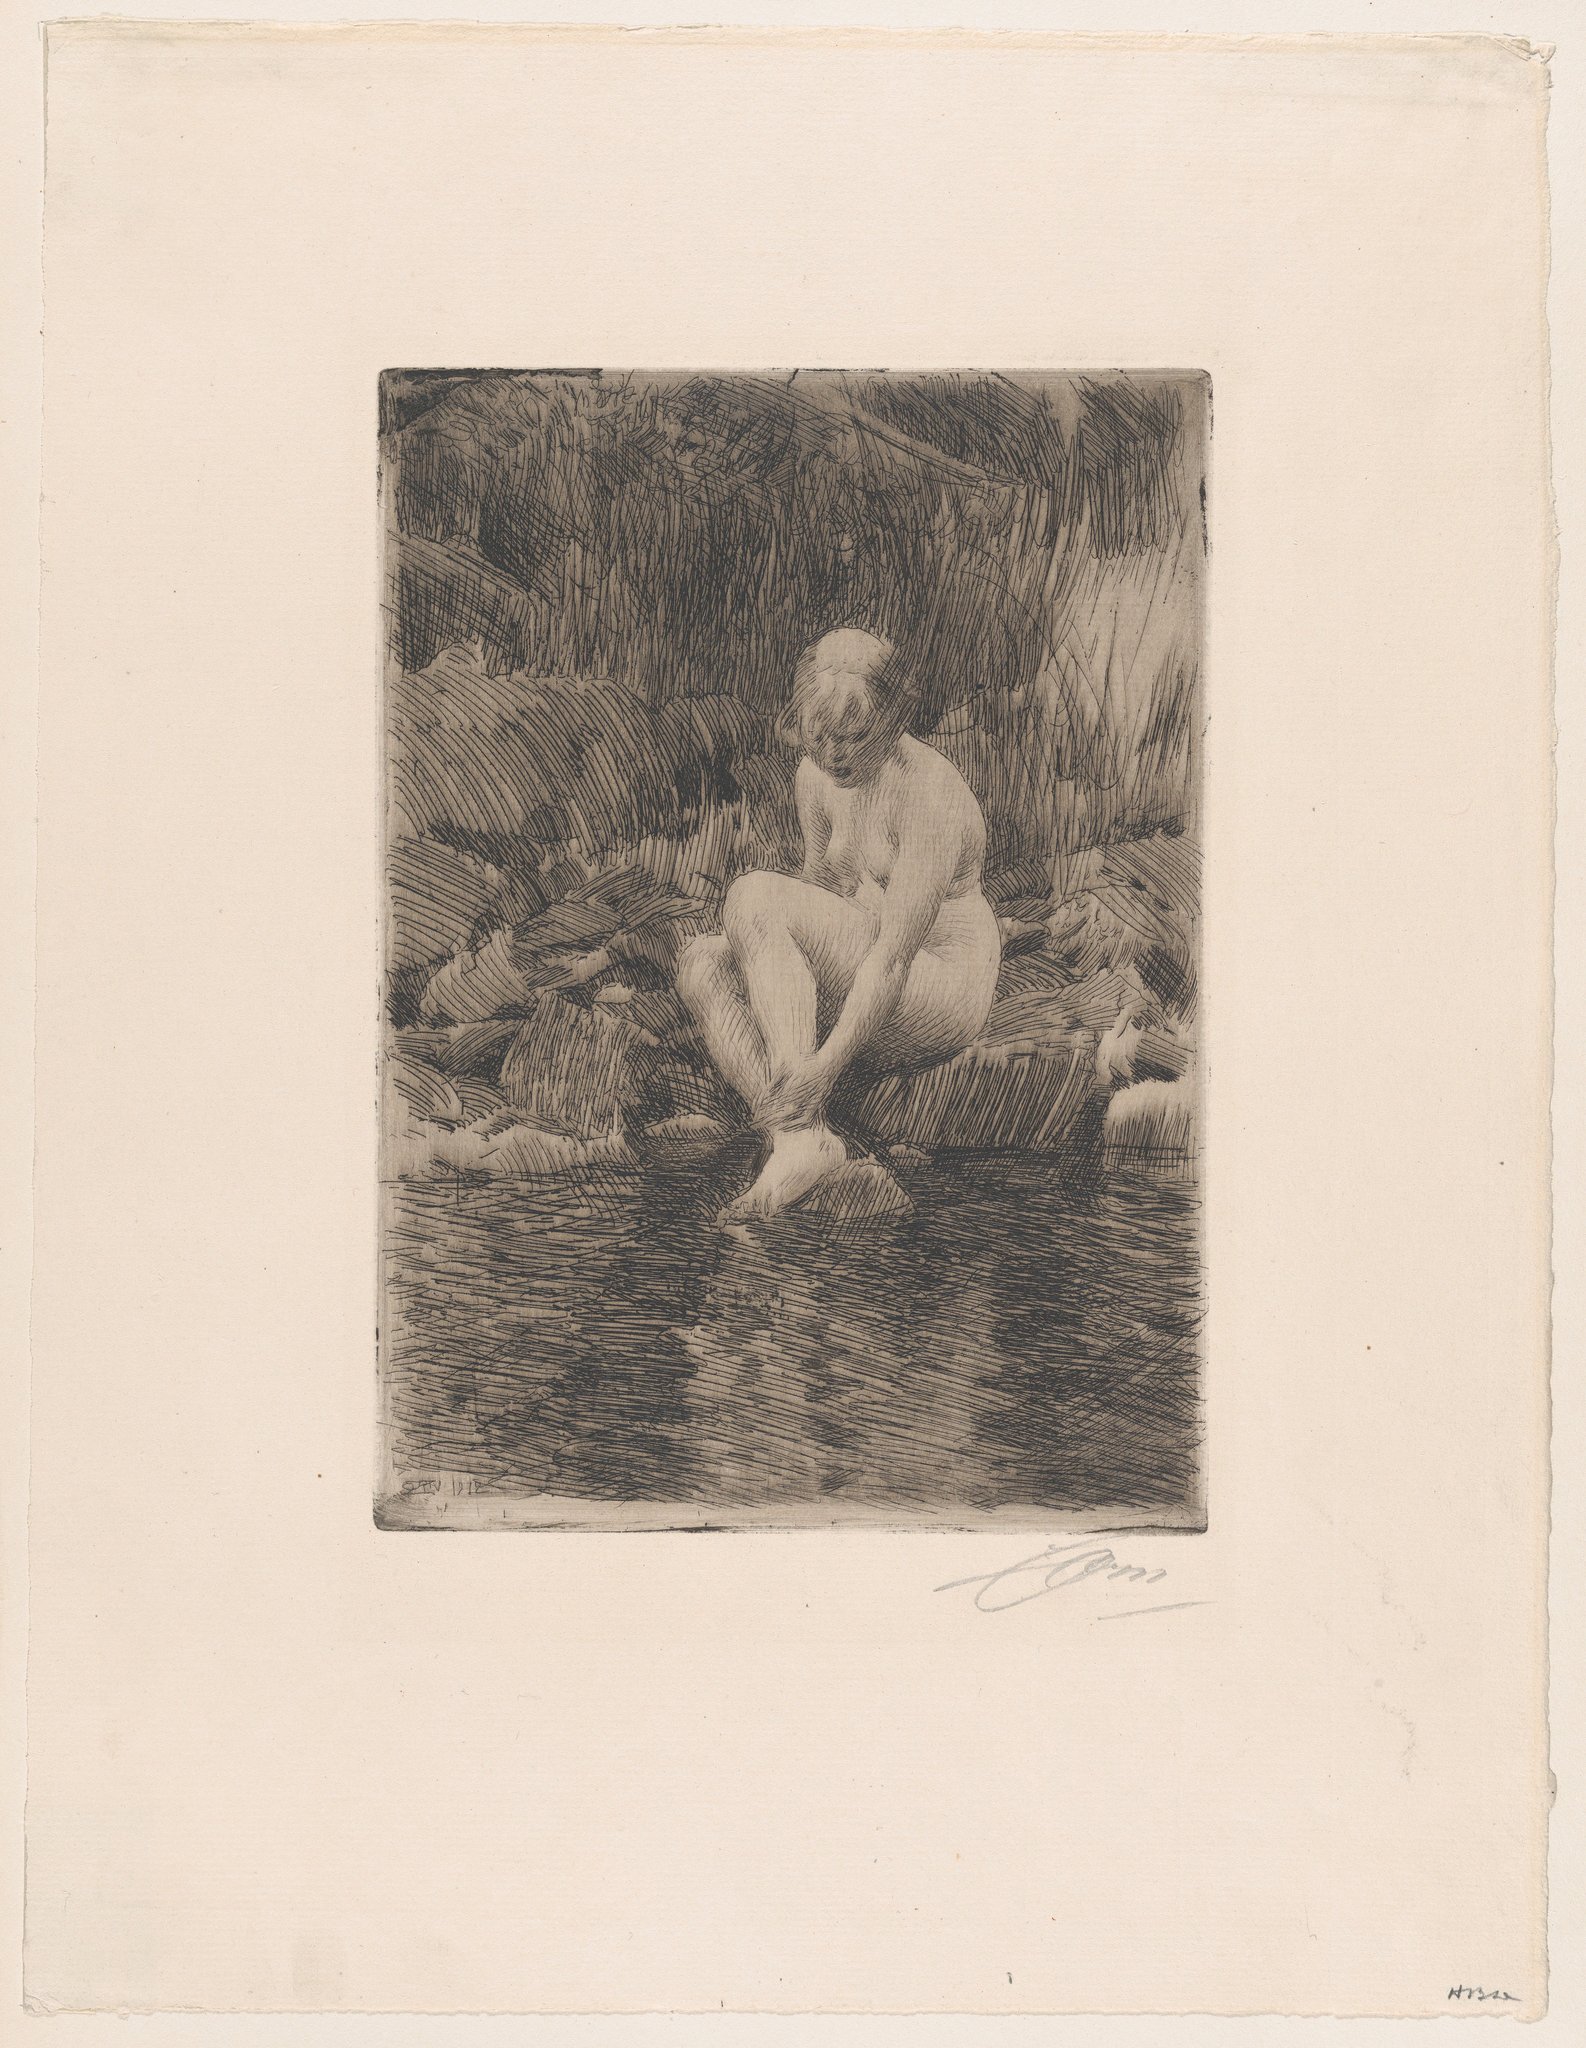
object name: print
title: Dagmar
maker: anders zorn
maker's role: artist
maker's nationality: swedish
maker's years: 1860-1920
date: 1912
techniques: etching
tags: female nudes